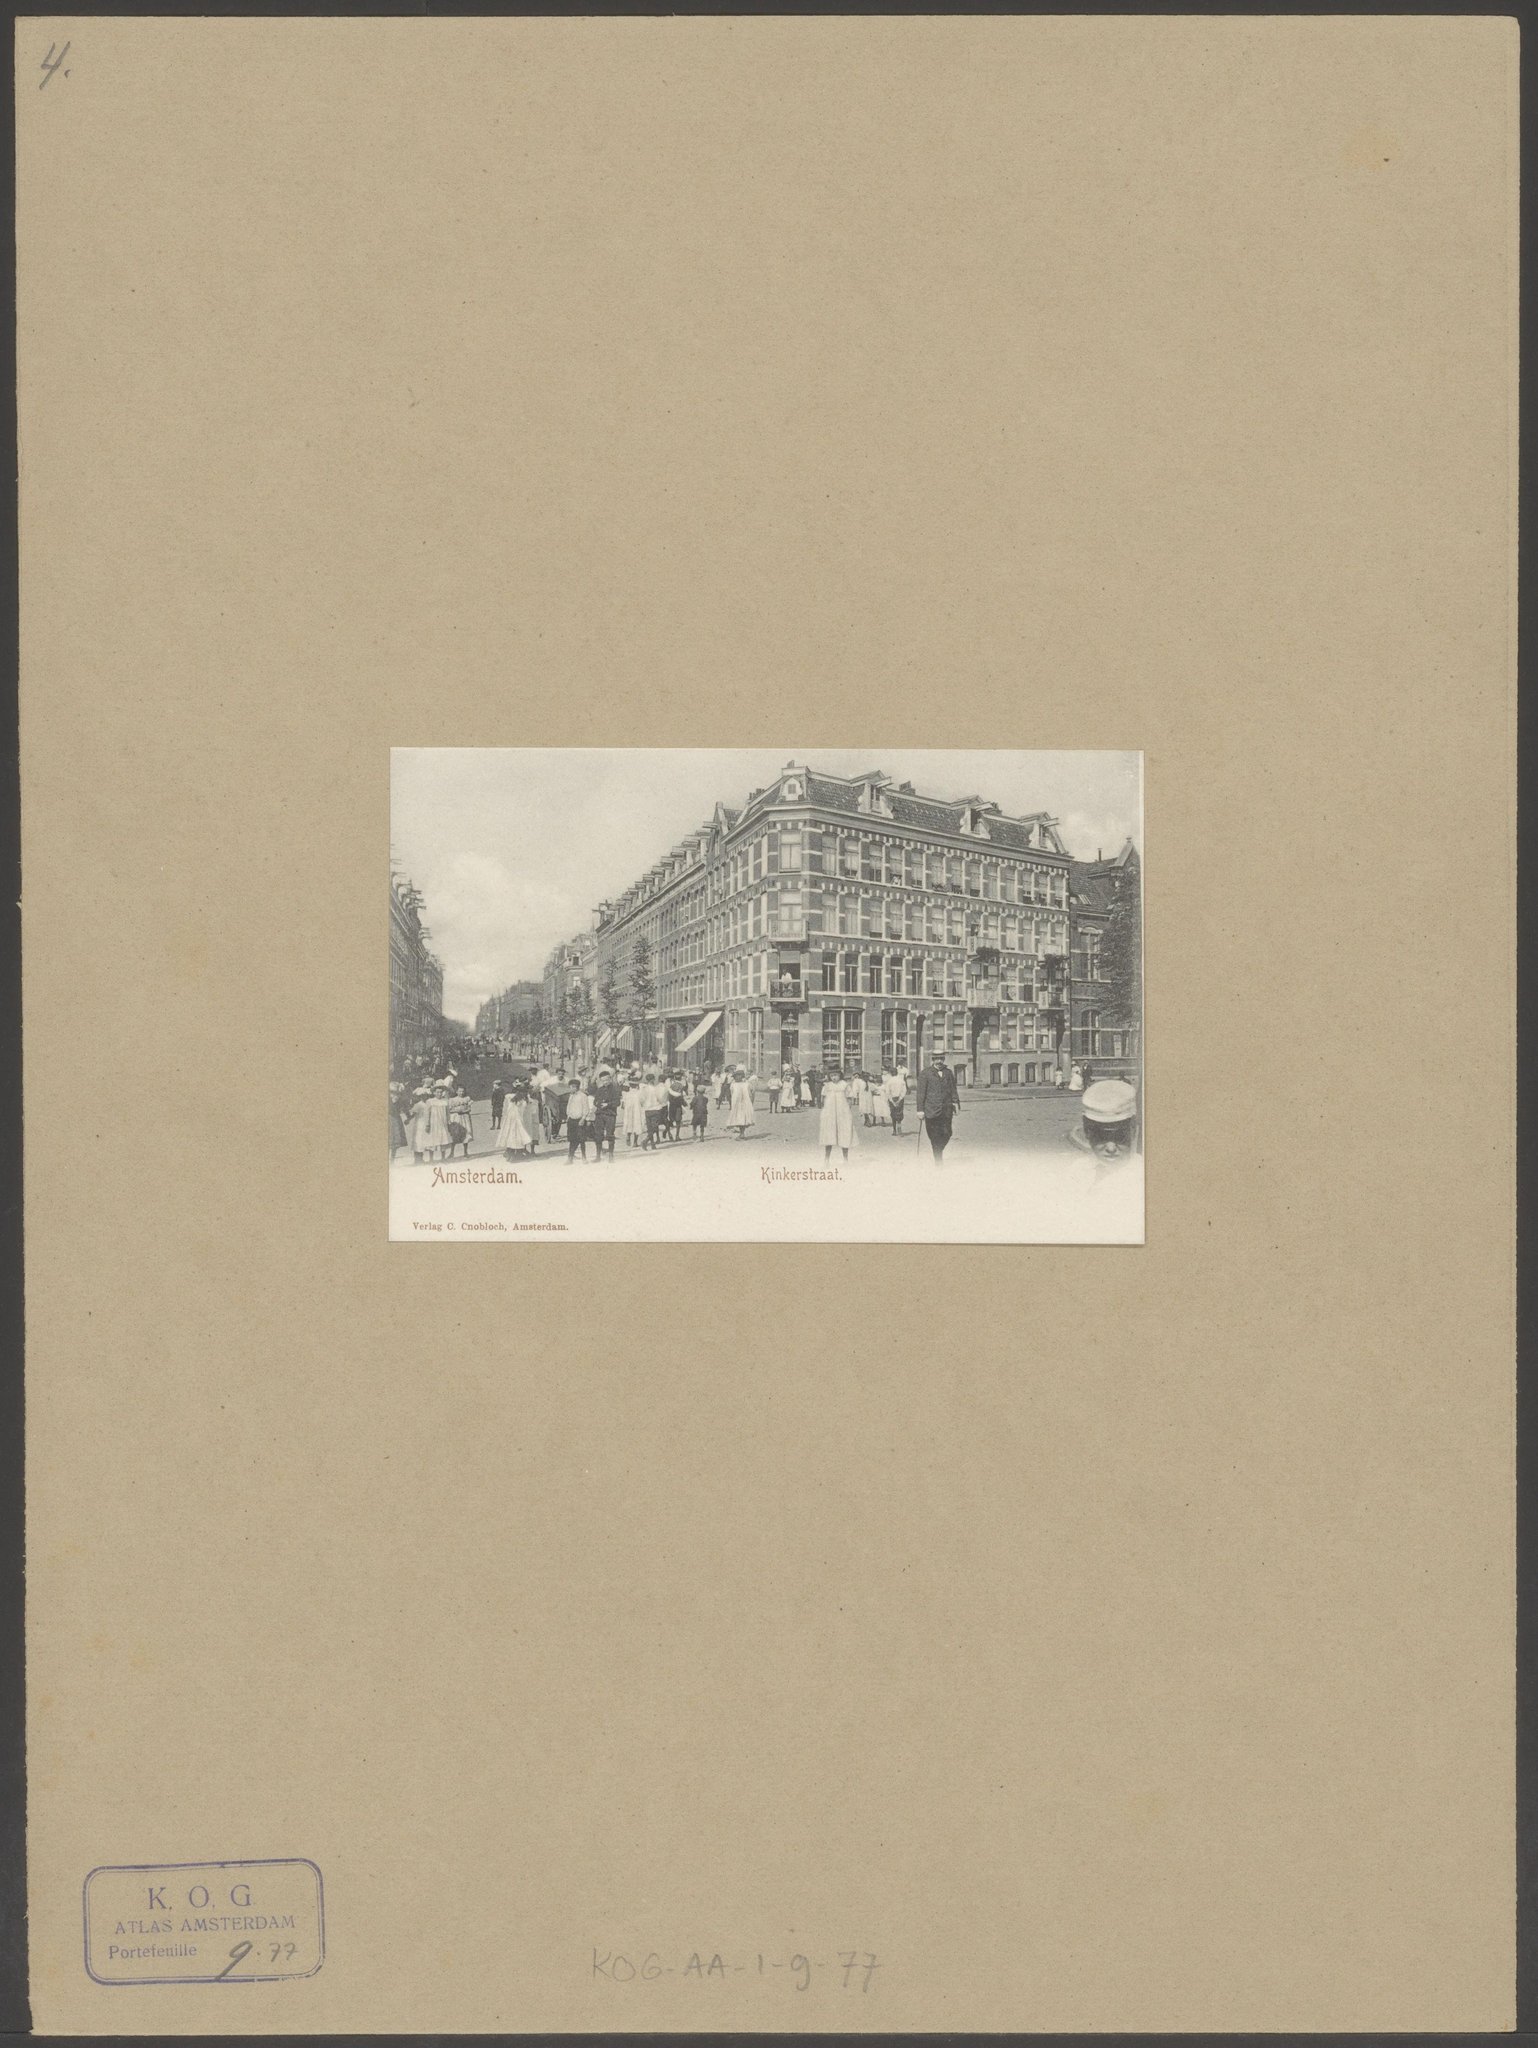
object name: photomechanical print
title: Gezicht op de Kinkerstraat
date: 1875-1905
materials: cardboard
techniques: photograph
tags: city-view in general; 'veduta', the usual house or row of houses, street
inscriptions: collector's mark: ‘9.77’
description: Onderwerpsrubriek binnen de Atlas Amsterdam: Kadijksplein, Karthuizerkerkhof, Kattegat, Kattenburg, Kapelsteeg O.Z., Enge Kerksteeg, Kerkstraat, Kinkerstraat, Kolk O.Z., Koningsplein, Kromboomsloot [Krom Boomssloot], Kostverlorenkade, Kwakersdwarspad, Kalverstraat, Keizersgracht (v.d. Brouwersgracht – Amstel), Klerensloot (Gedempte), Klimopstraat, Kloveniersburgwal, Kraansluis.